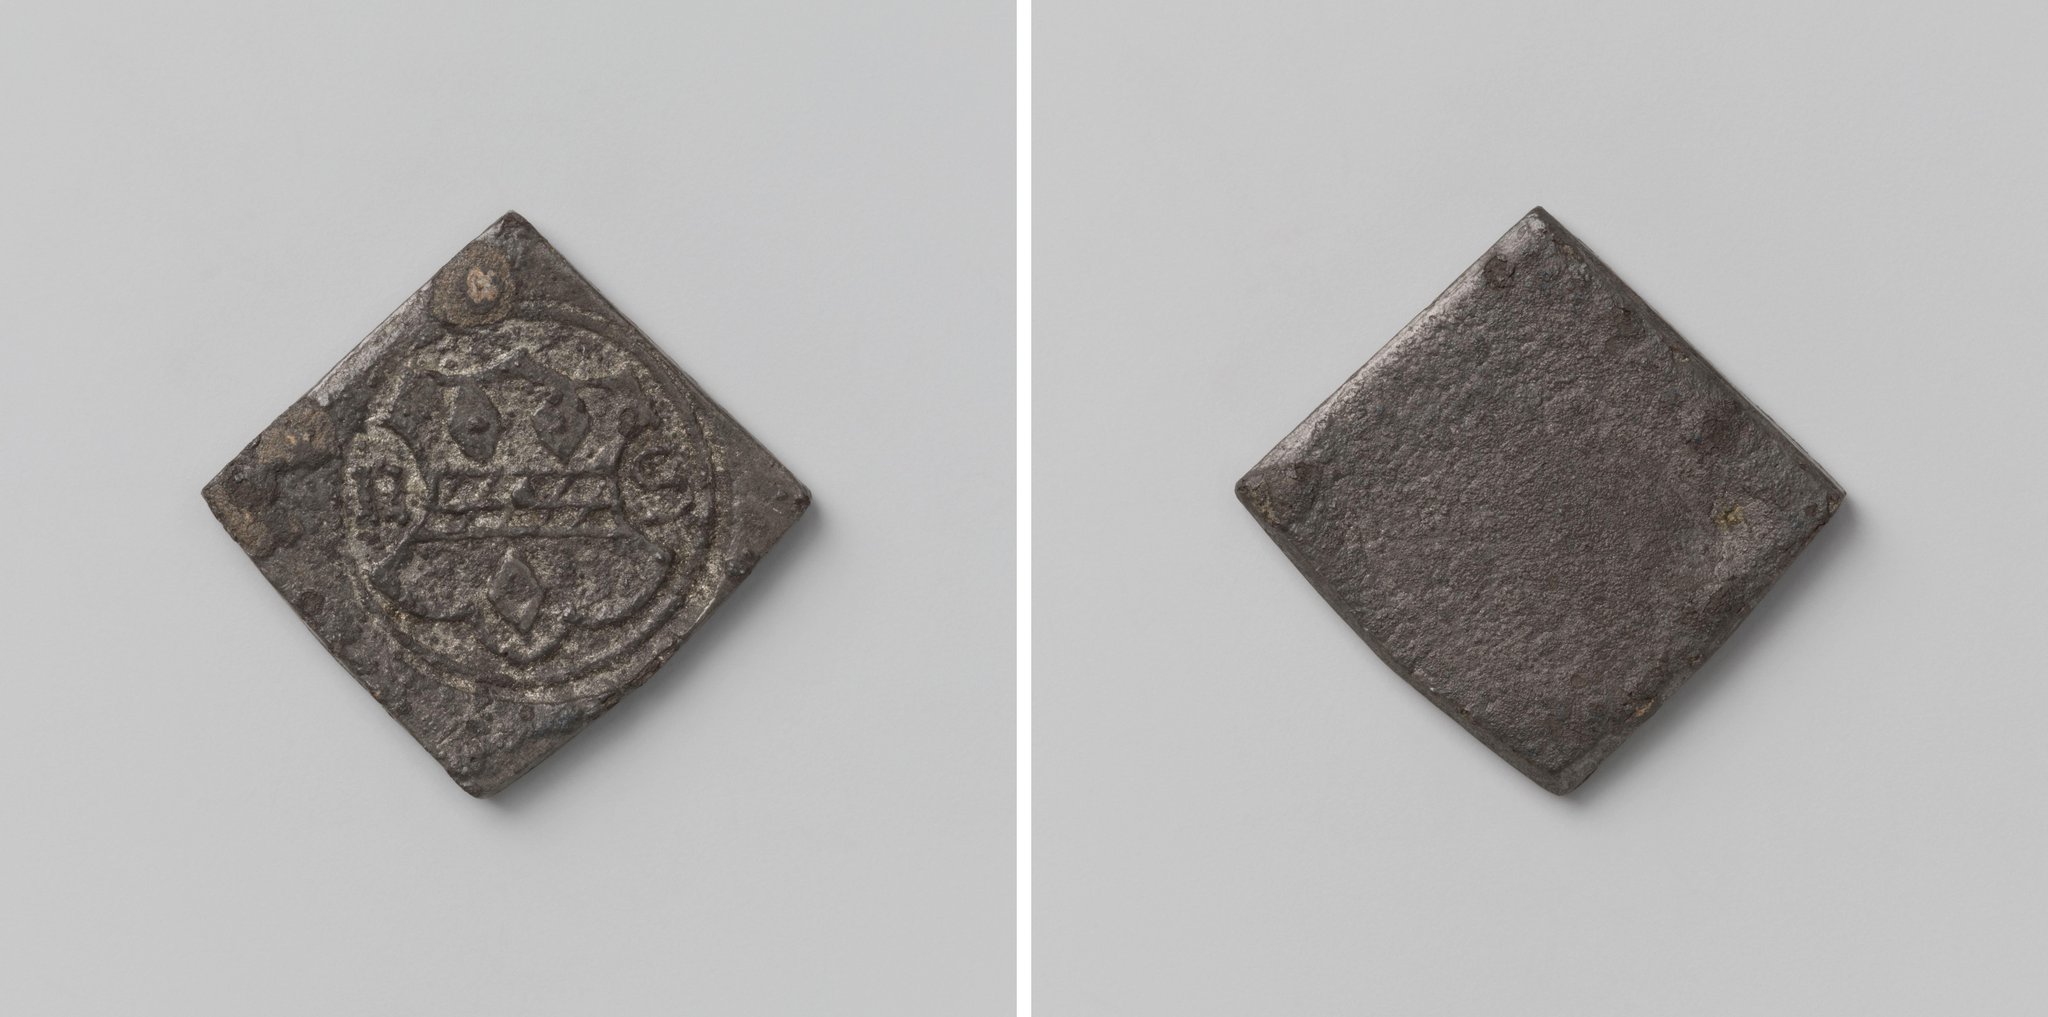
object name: halve stuiver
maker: Anonymous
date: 1575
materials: tin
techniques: striking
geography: woerden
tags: woerden, beleg van woerden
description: eenzijdige, ruitvormige, tinnen noodmunt van een halve stuiver uit Woerden. Voorzijde: wapenschild tussen II en S. Keerzijde: blanco.